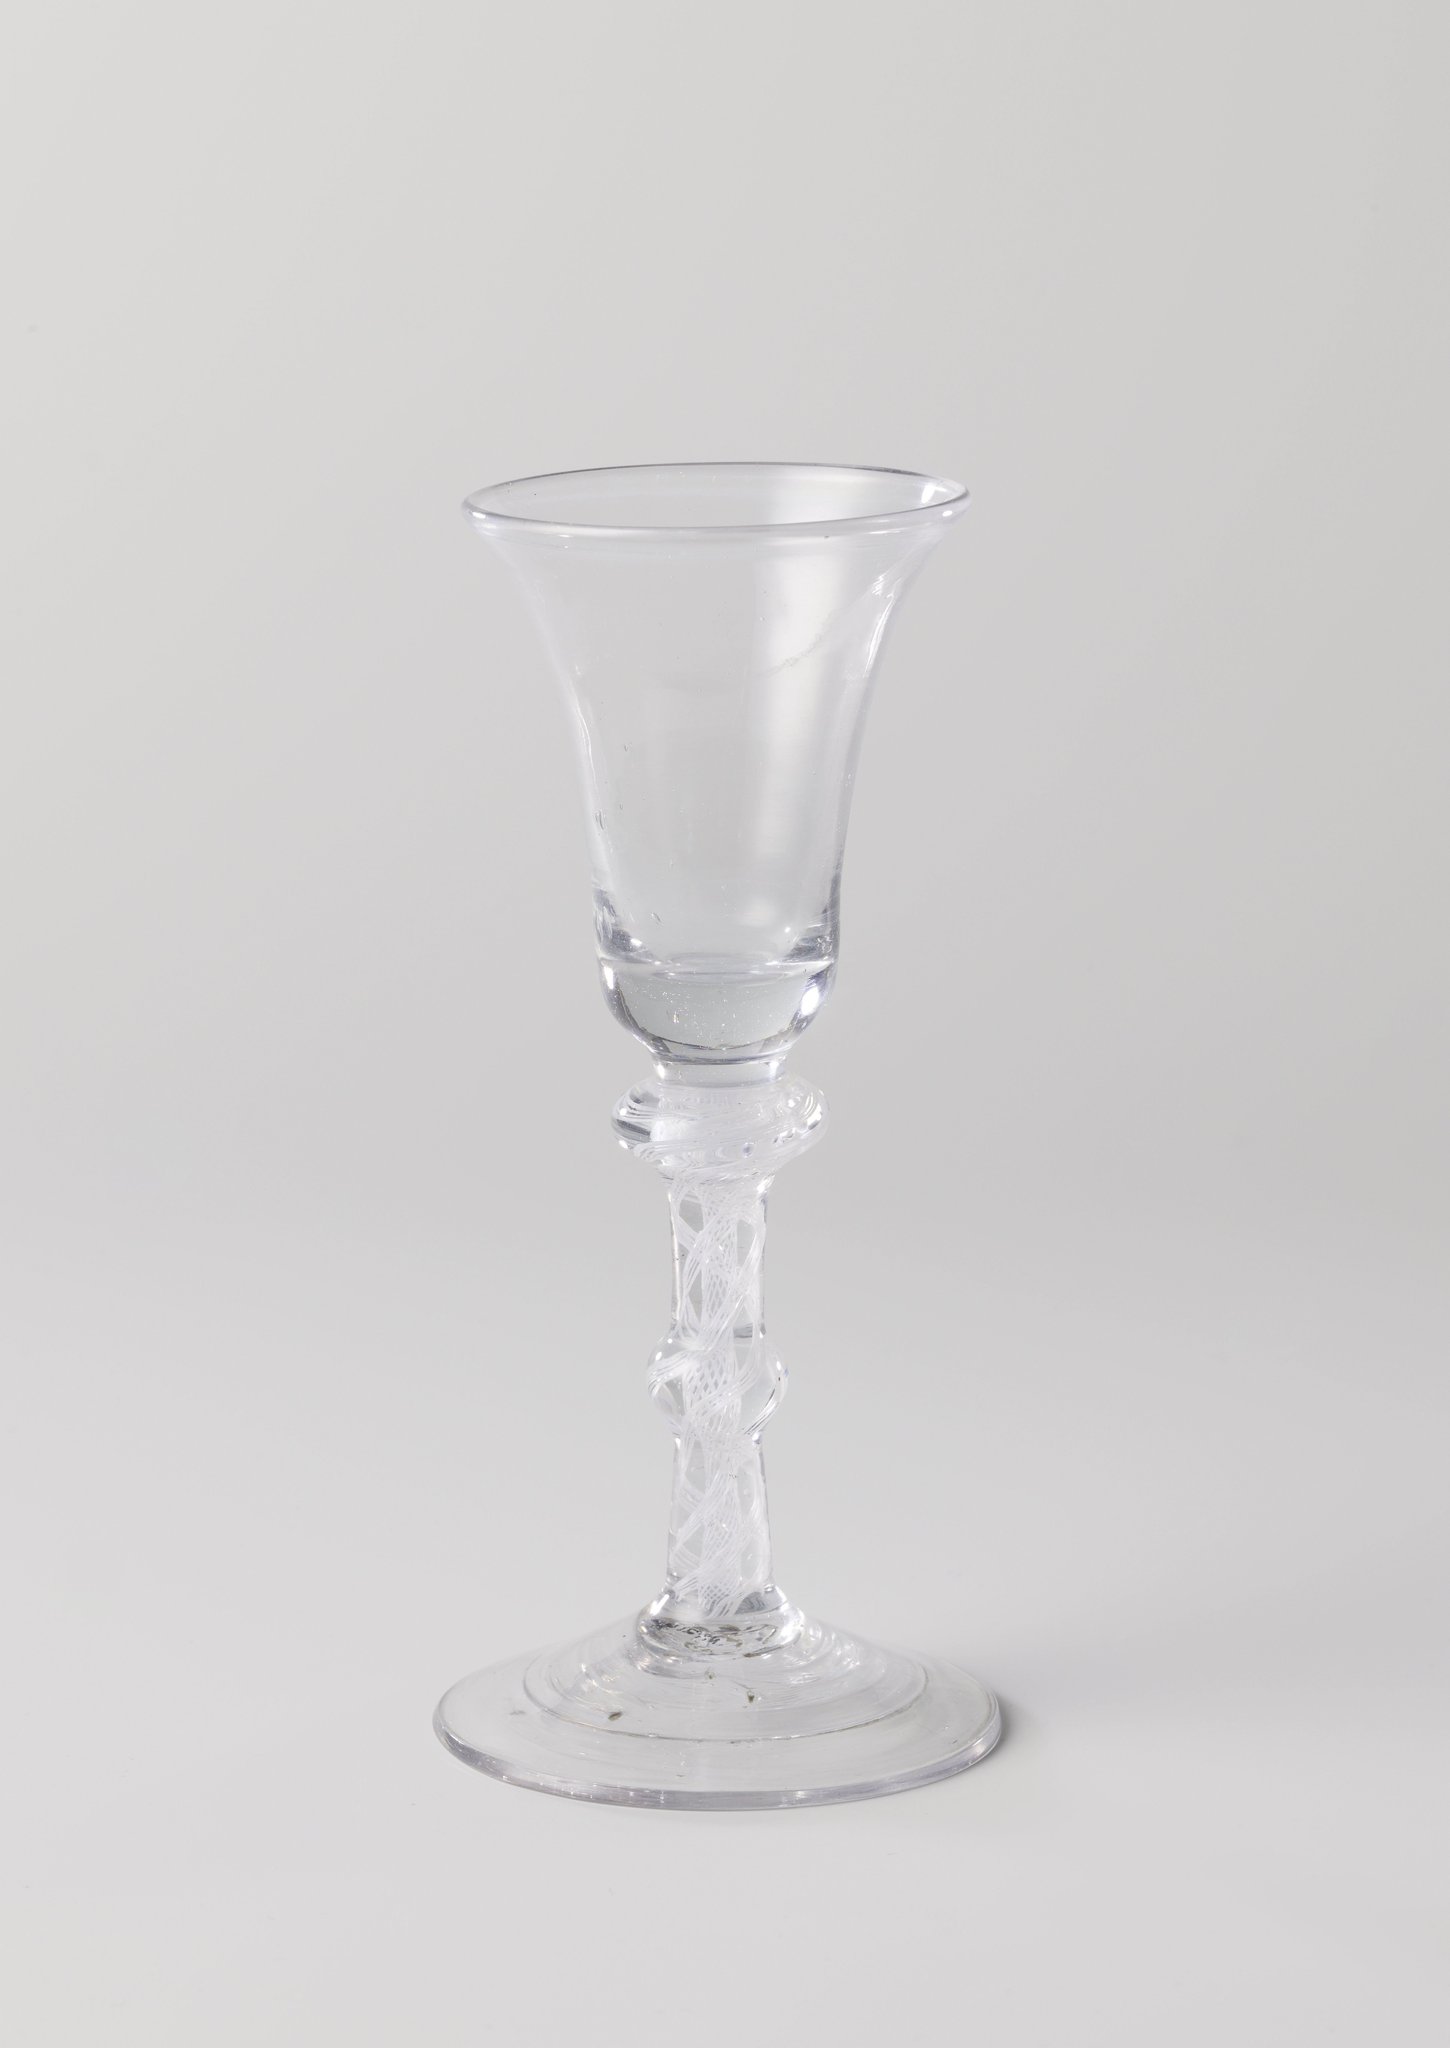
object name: goblet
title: Slingerglas met klokvormige kelk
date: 1750-1775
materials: glass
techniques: glassblowing, vetro a retorti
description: Slingerglas met conische voet en balustroïde stam. In de stam opaak witte slingers rond witte netwerkspiraal. Klokvormige kelk.